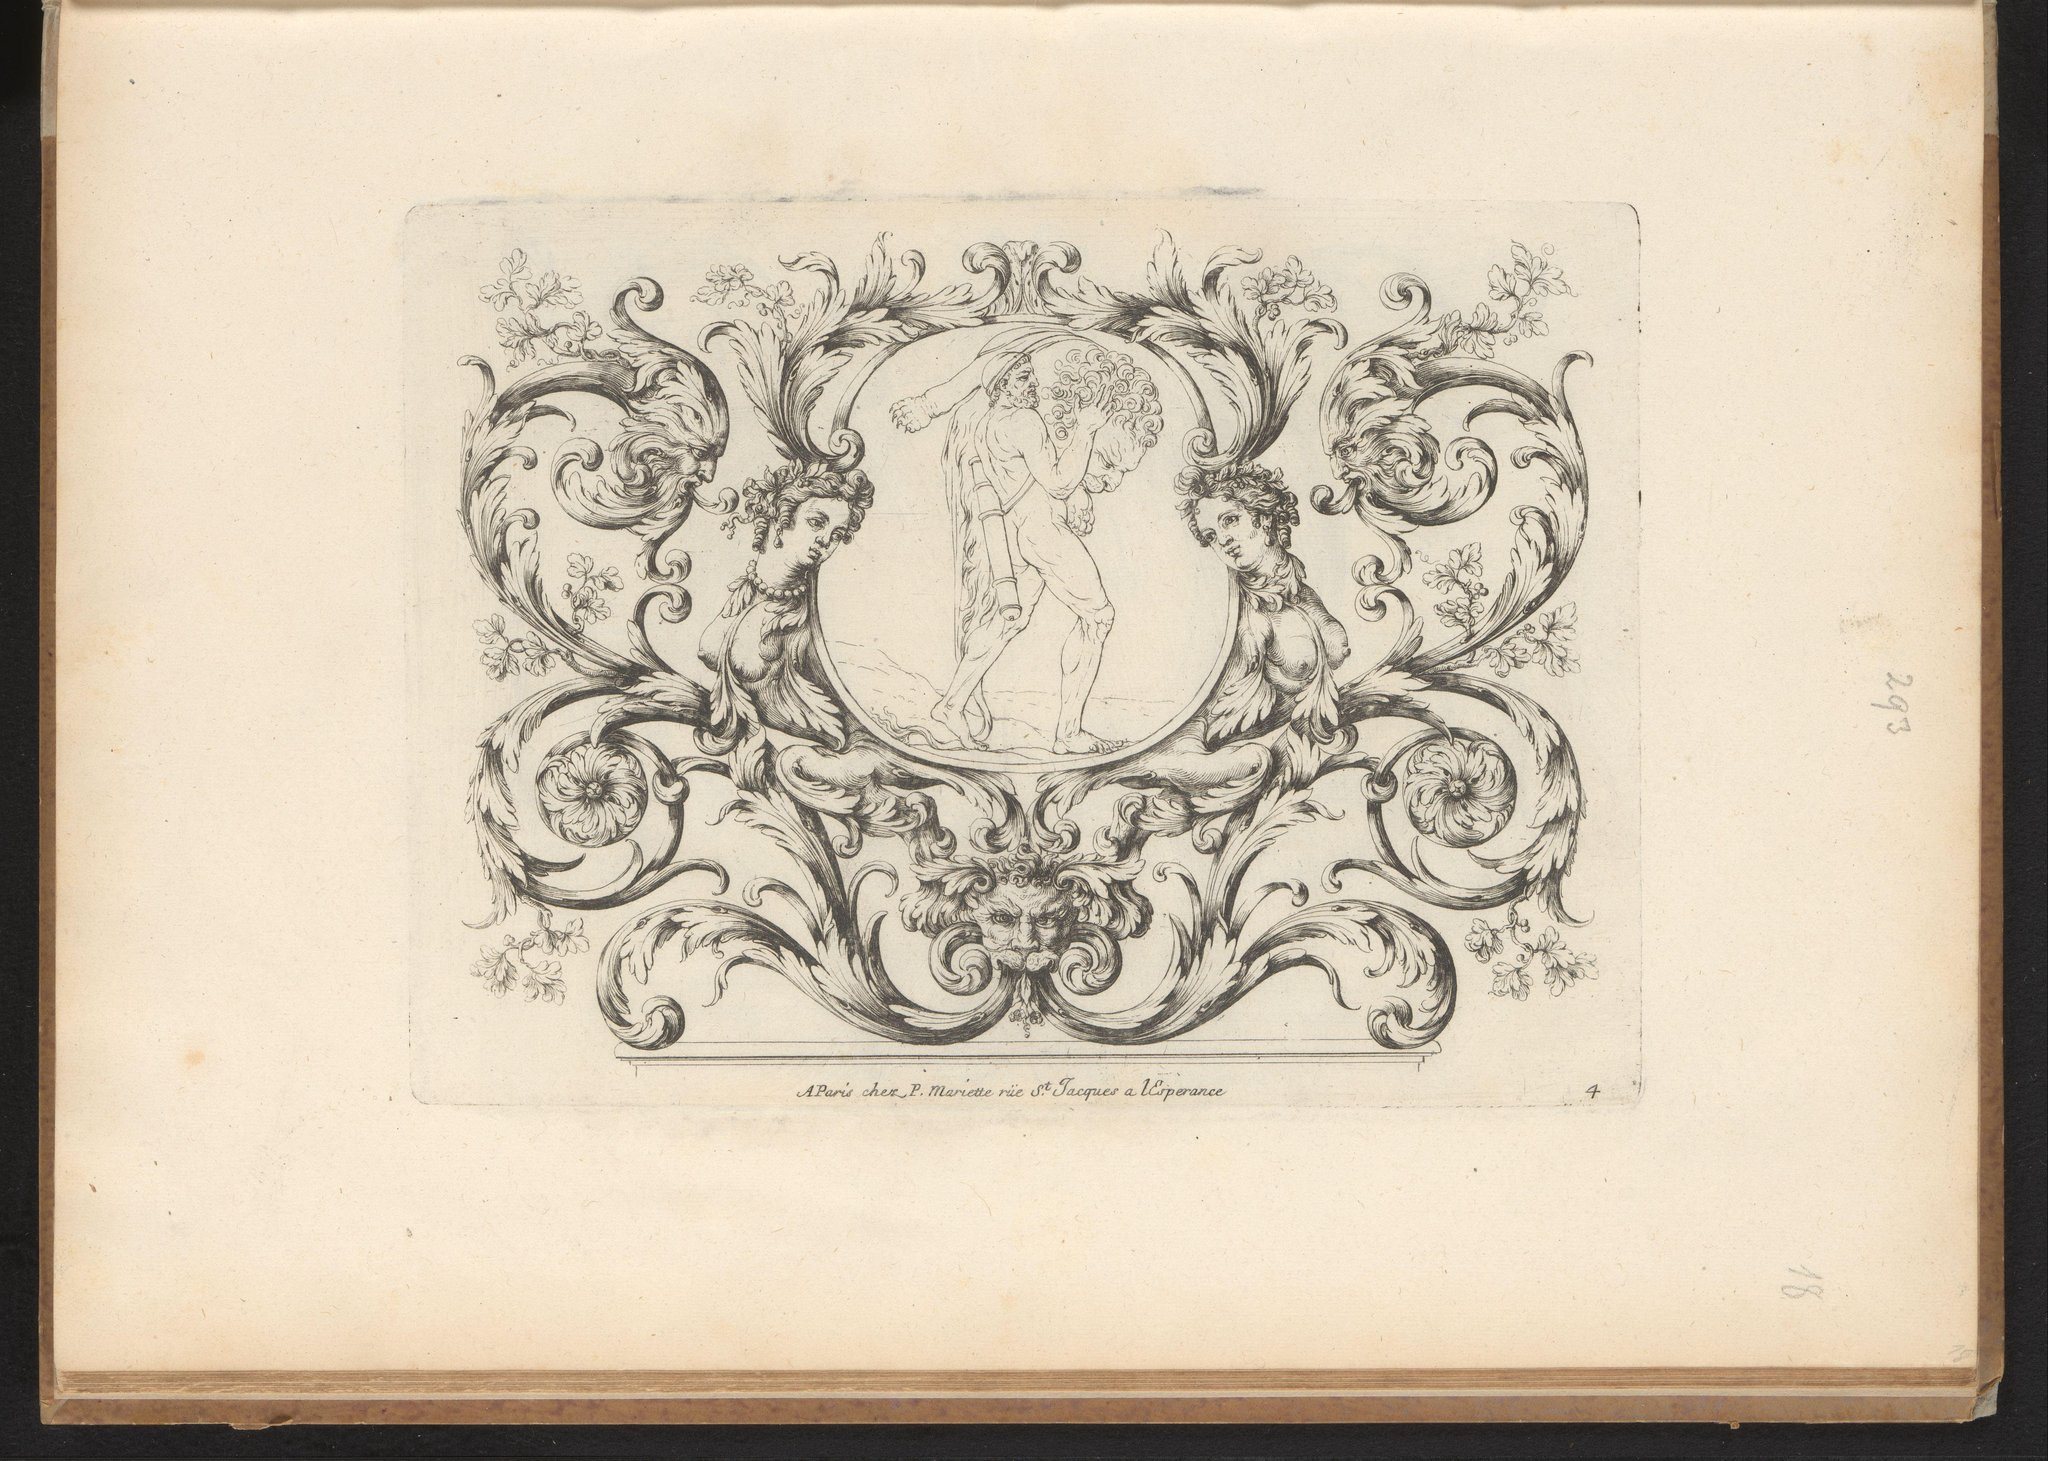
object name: album leaf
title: Panelen met bladmotieven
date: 1660-1690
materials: paper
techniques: etching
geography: paris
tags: attributes of hercules (with name), sphinx (lion/woman); 'sfinge' (ripa), acanthus ~ ornament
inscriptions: collector's mark: Lugt 2228a, collector's mark: Lugt 2760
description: Deze prent maakt deel uit van een album.